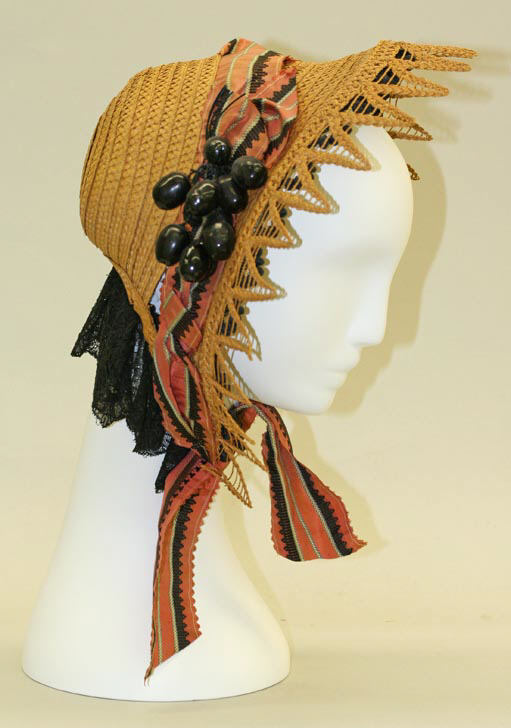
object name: bonnet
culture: american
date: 1858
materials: fiber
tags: cherries